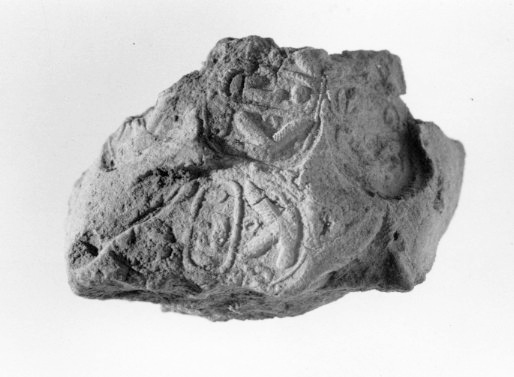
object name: sealing, nebmaatre, amenhotep iii, horus, falcon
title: Document Sealing with the Throne Name of Amenhotep III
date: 1390-1352 BCE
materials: mud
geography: egypt